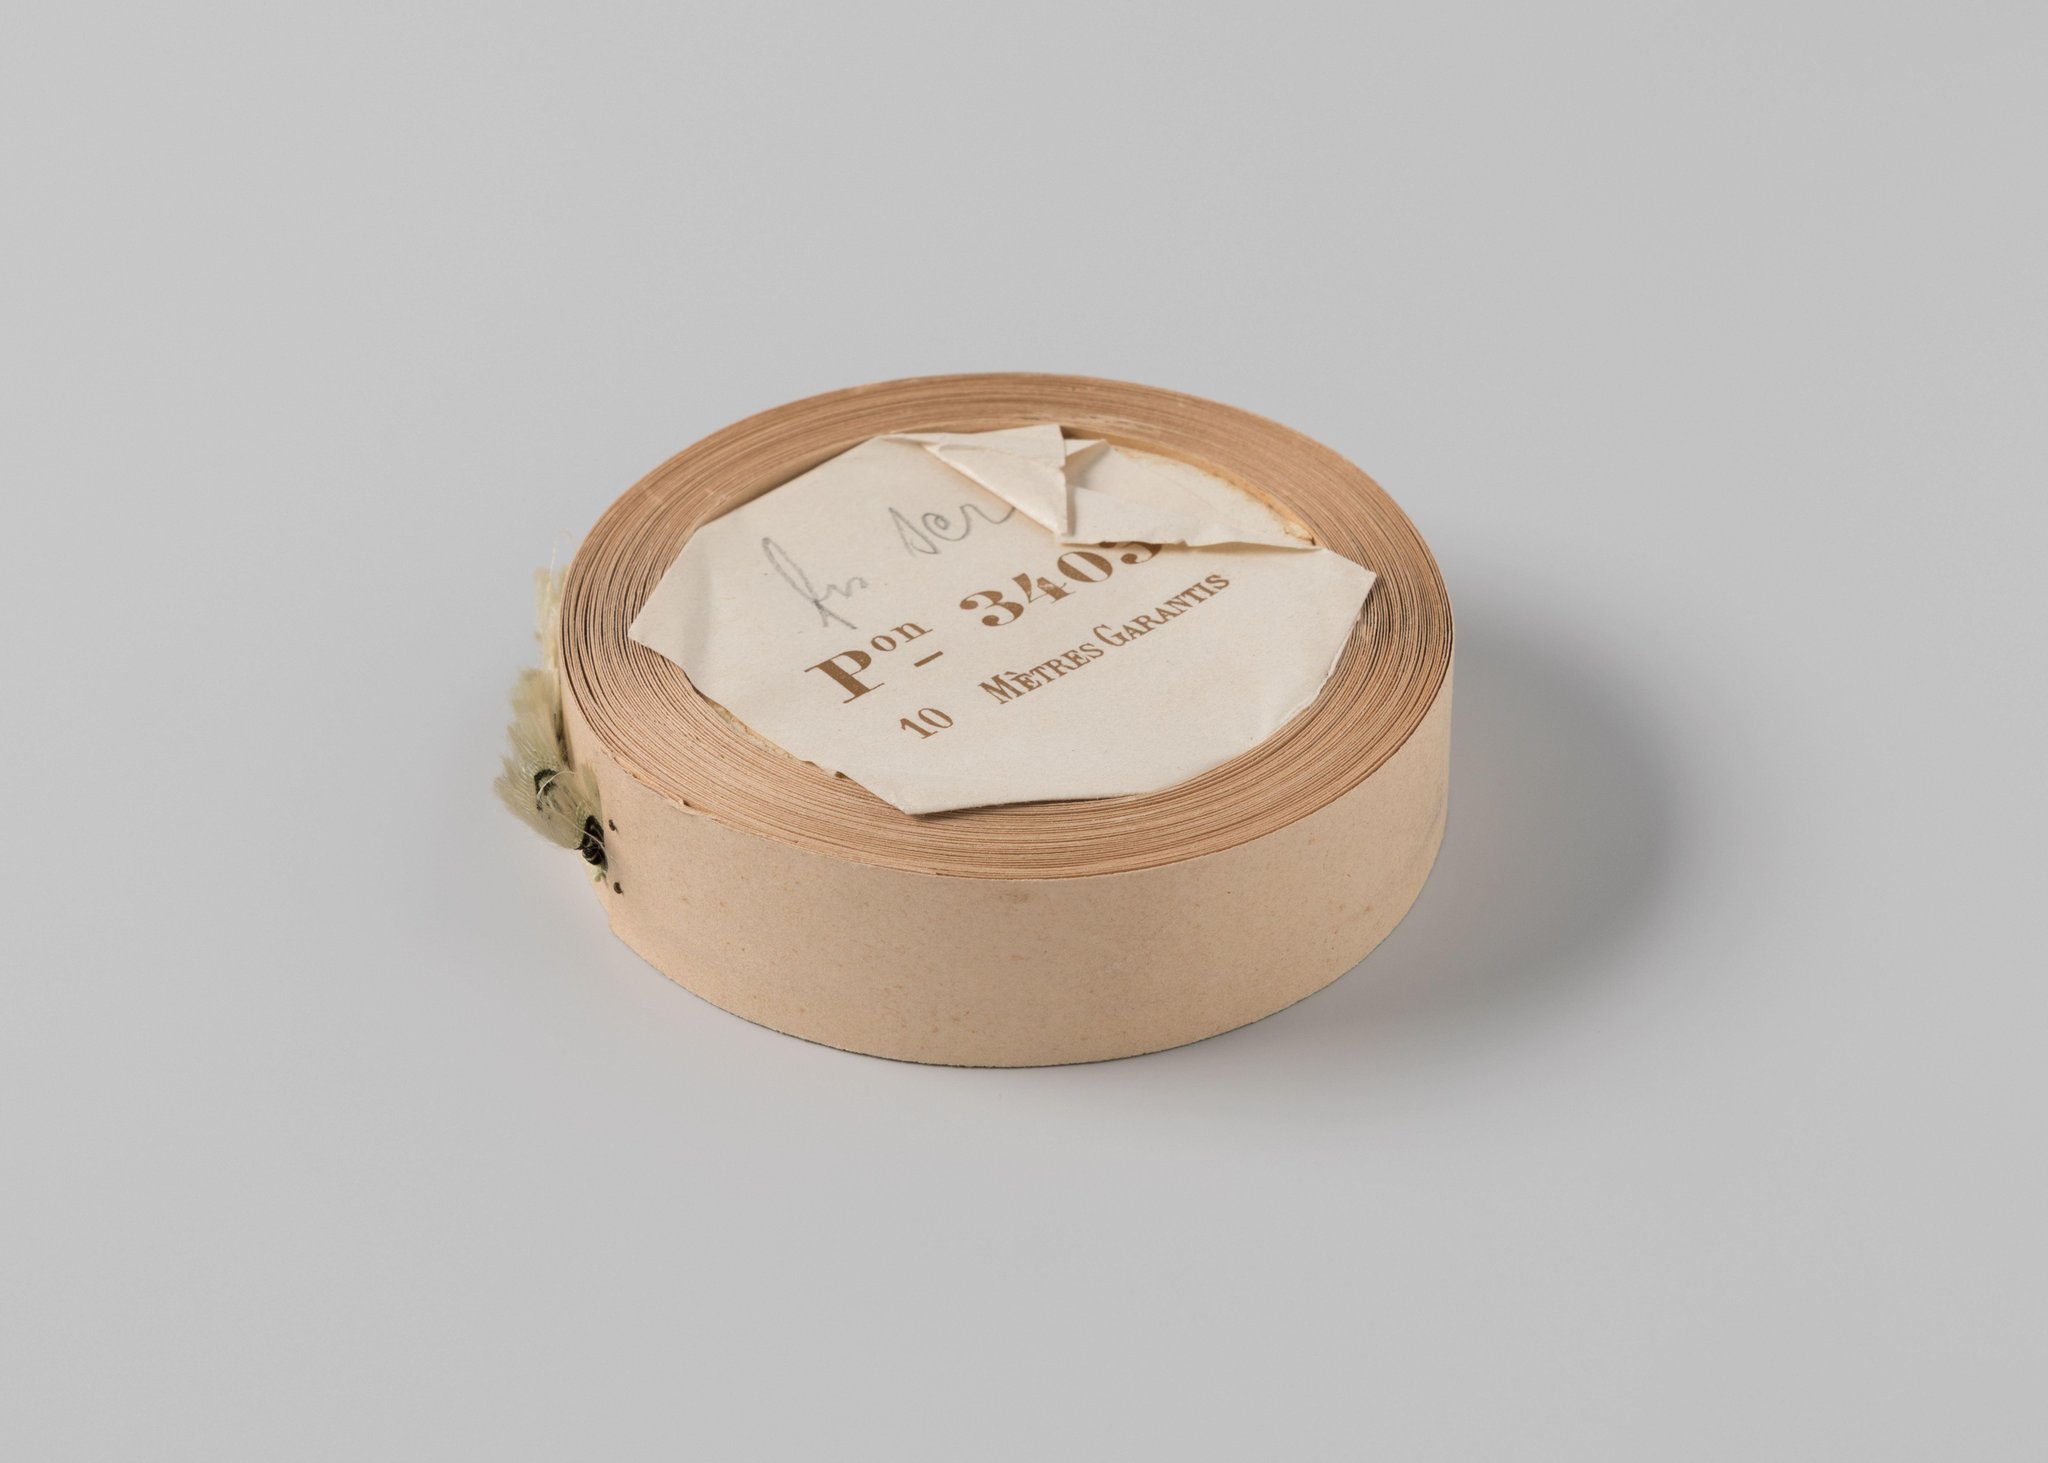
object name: braid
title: Rol met lichtgroen lint met één gerafelde zijde en drie zwarte horizontale strepen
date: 1930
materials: cardboard, paper, textile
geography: nijmegen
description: Rol met lichtgroen lint met één gerafelde zijde en drie zwarte horizontale strepen.